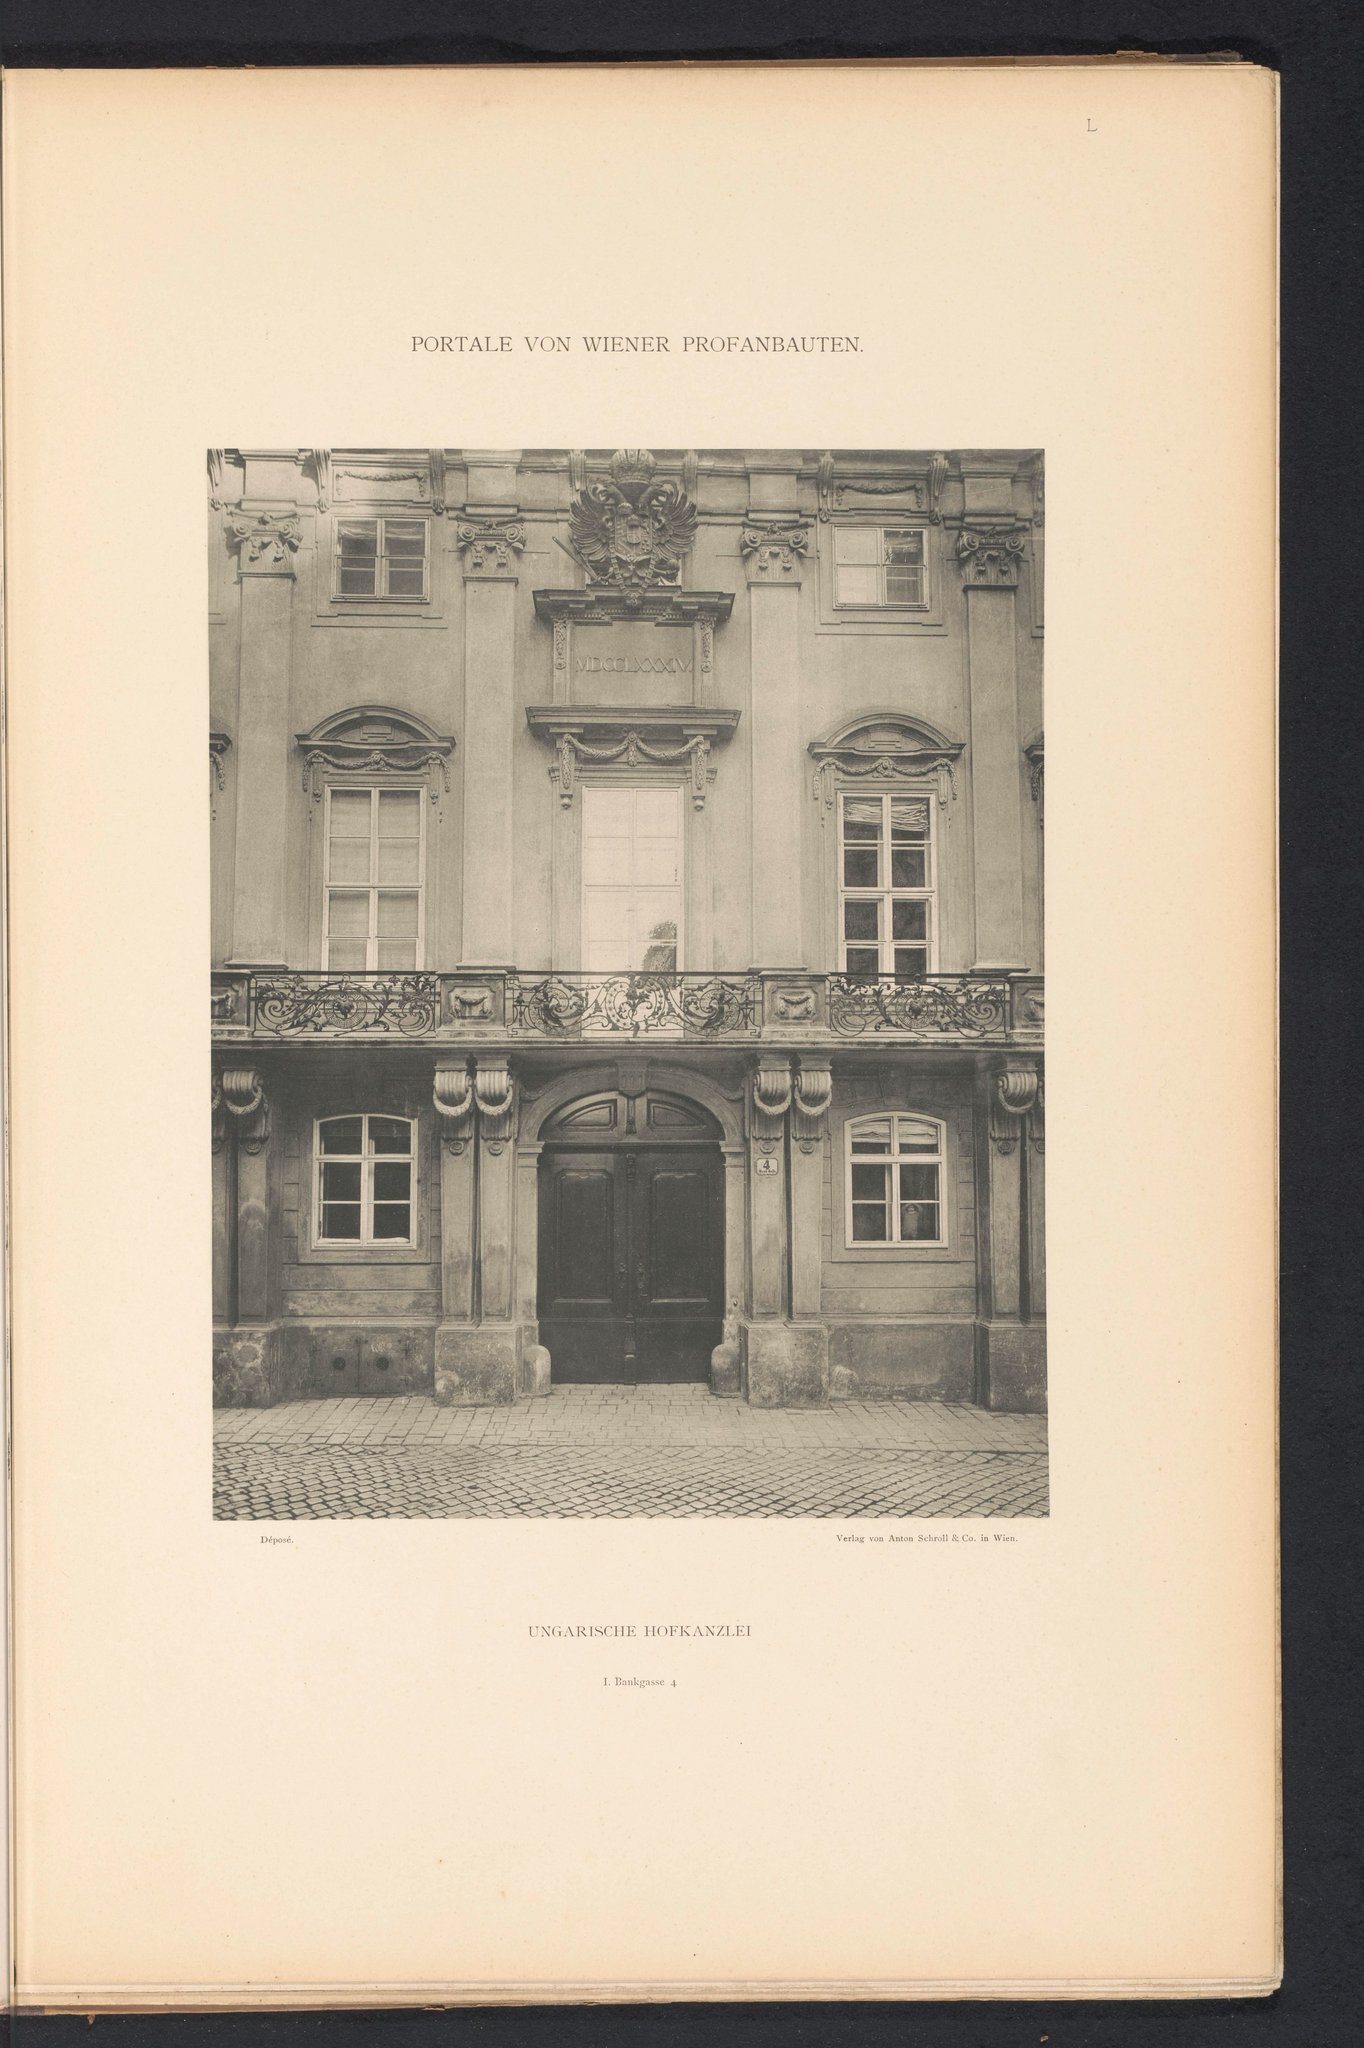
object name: page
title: Toegangsportaal van de Ungarische Hofkanzlei te Wenen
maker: Anonymous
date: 1884-1894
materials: paper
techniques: photograph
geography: vienna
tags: gate, entrance, façade (of house or building)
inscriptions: inscription: ‘I. Bankgasse 4’, number: ‘L.’